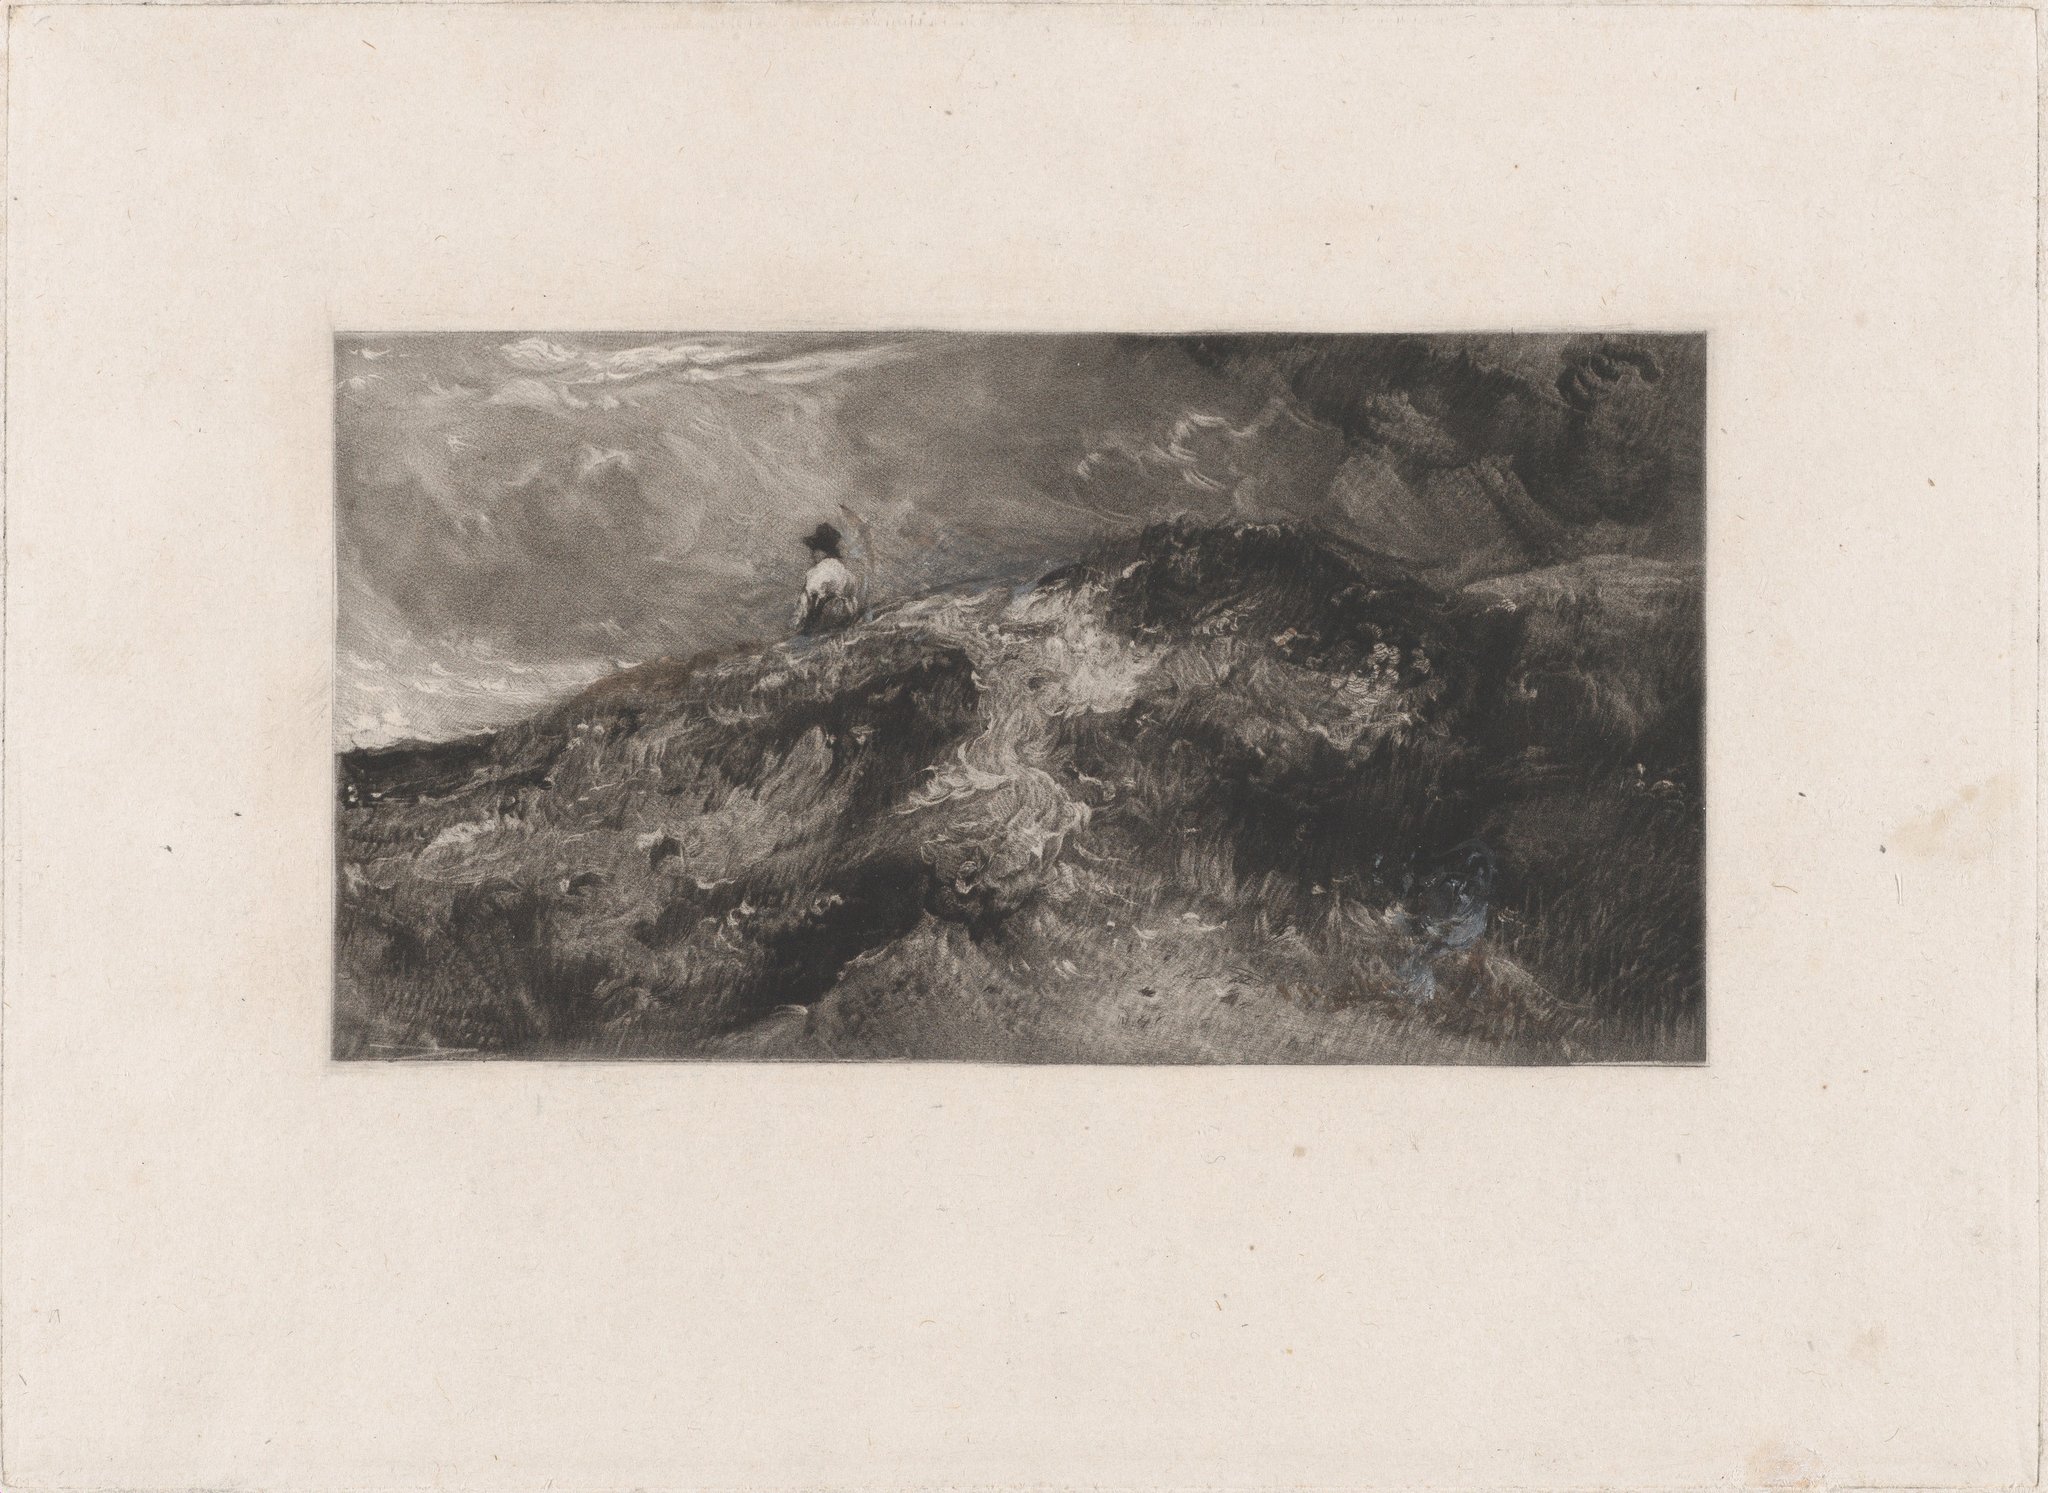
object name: print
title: Hampstead Heath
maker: david lucas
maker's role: artist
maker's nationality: british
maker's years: 1802-1881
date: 1829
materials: chalk, ink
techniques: mezzotint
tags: men,landscapes,storms